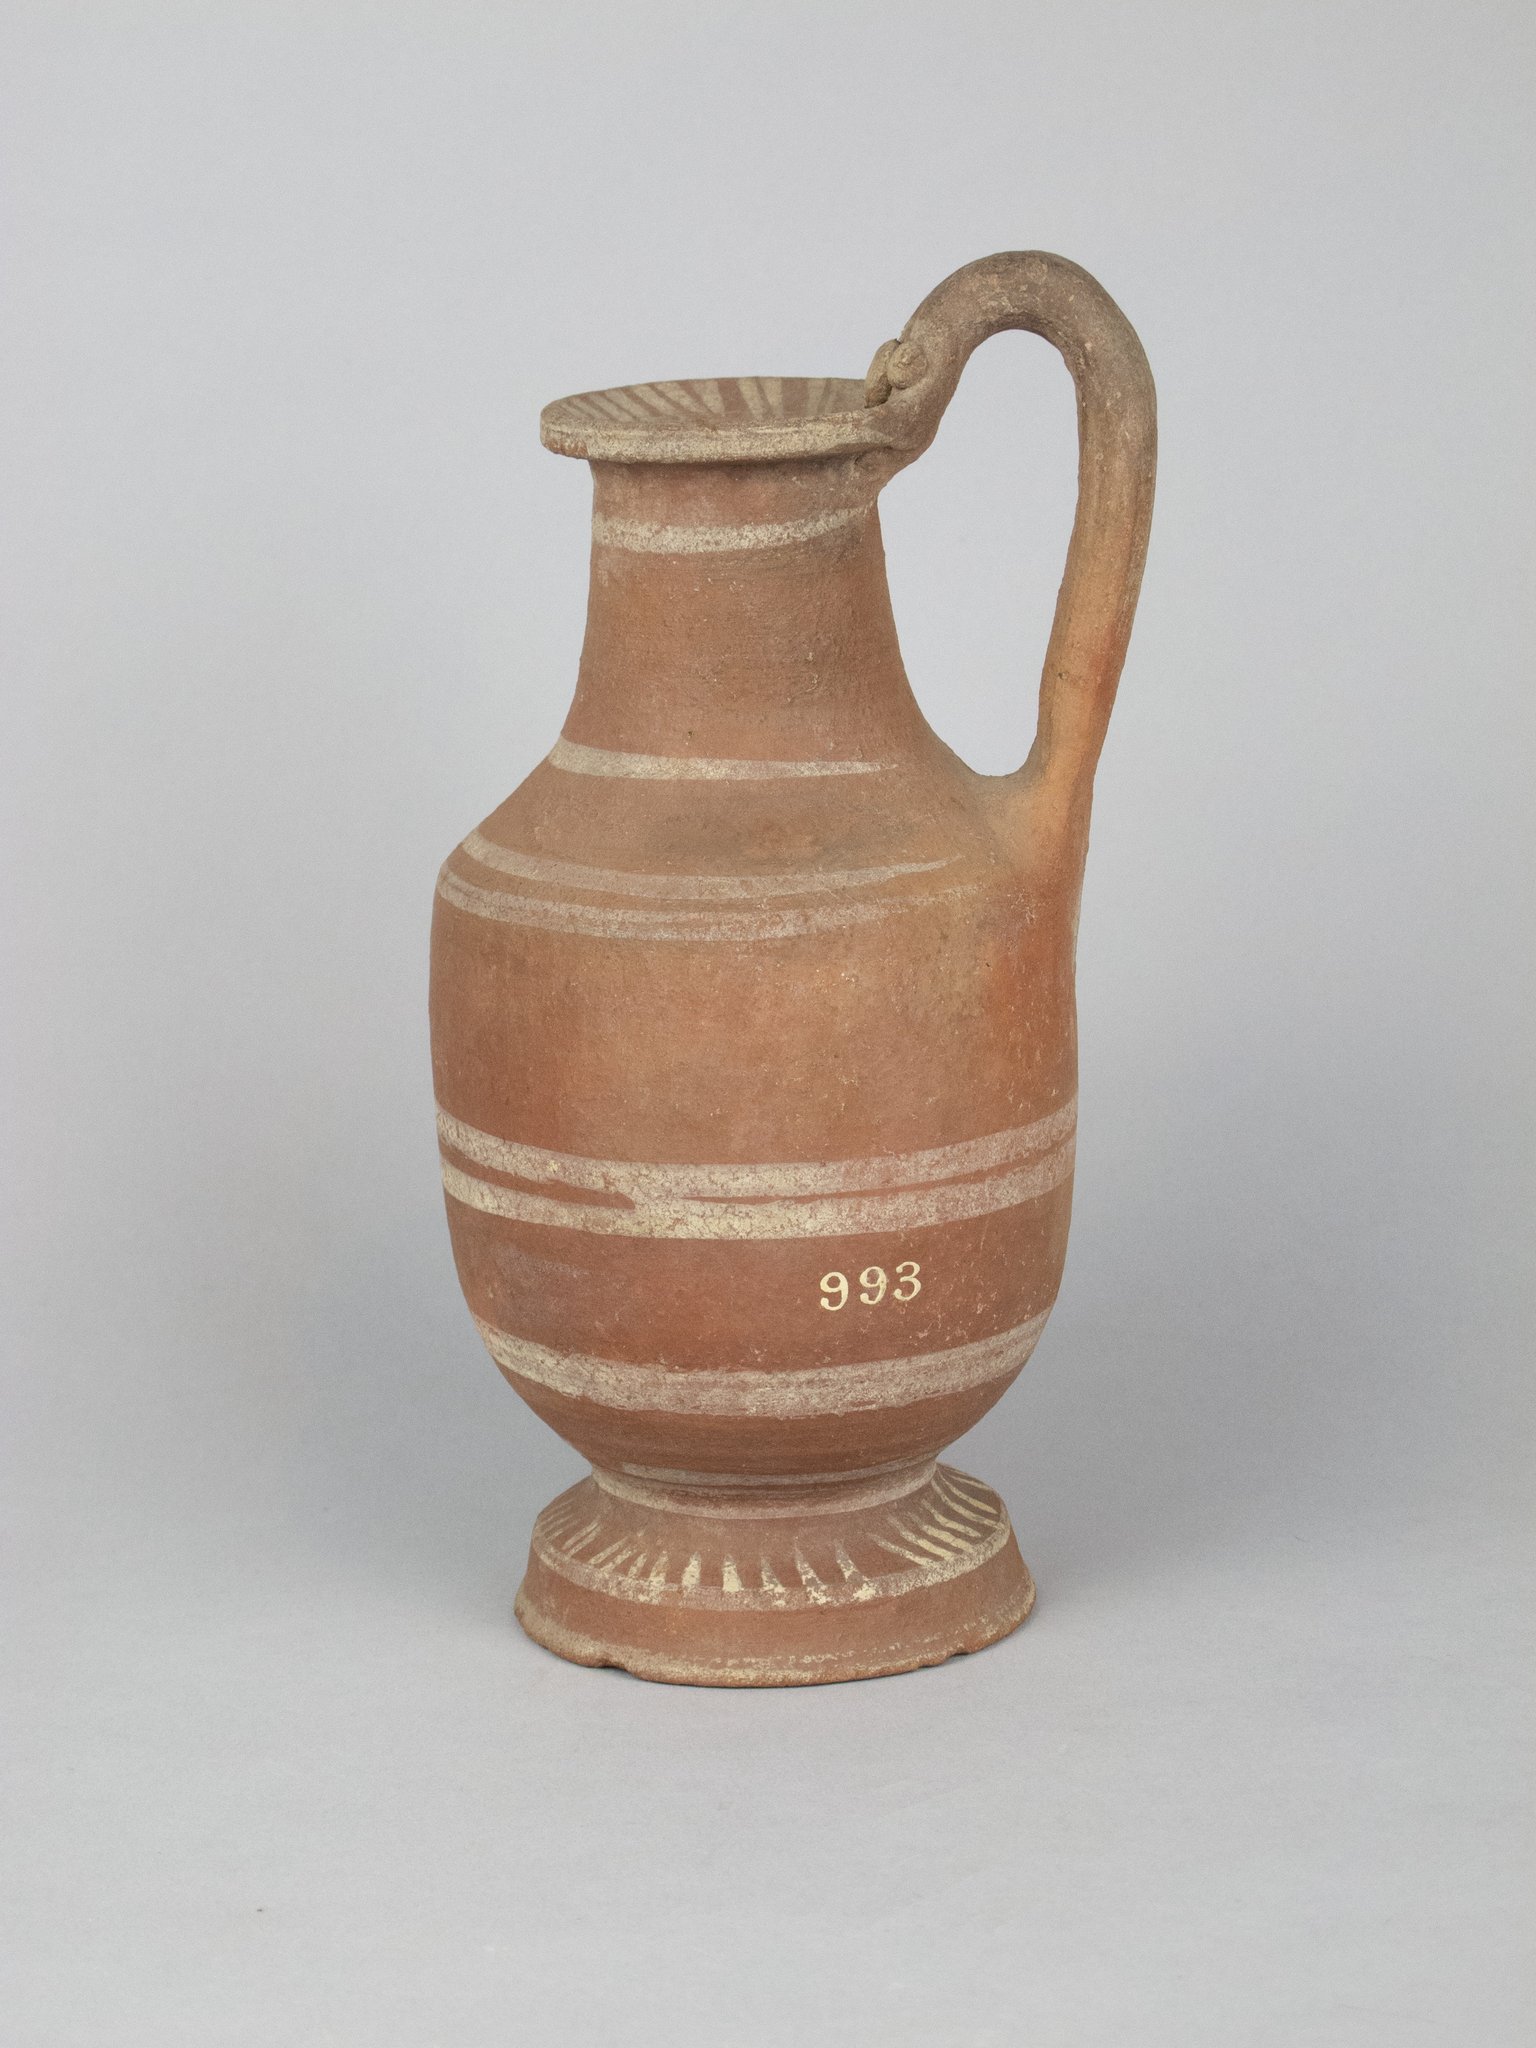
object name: jug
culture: cypriot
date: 480-310 BCE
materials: terracotta